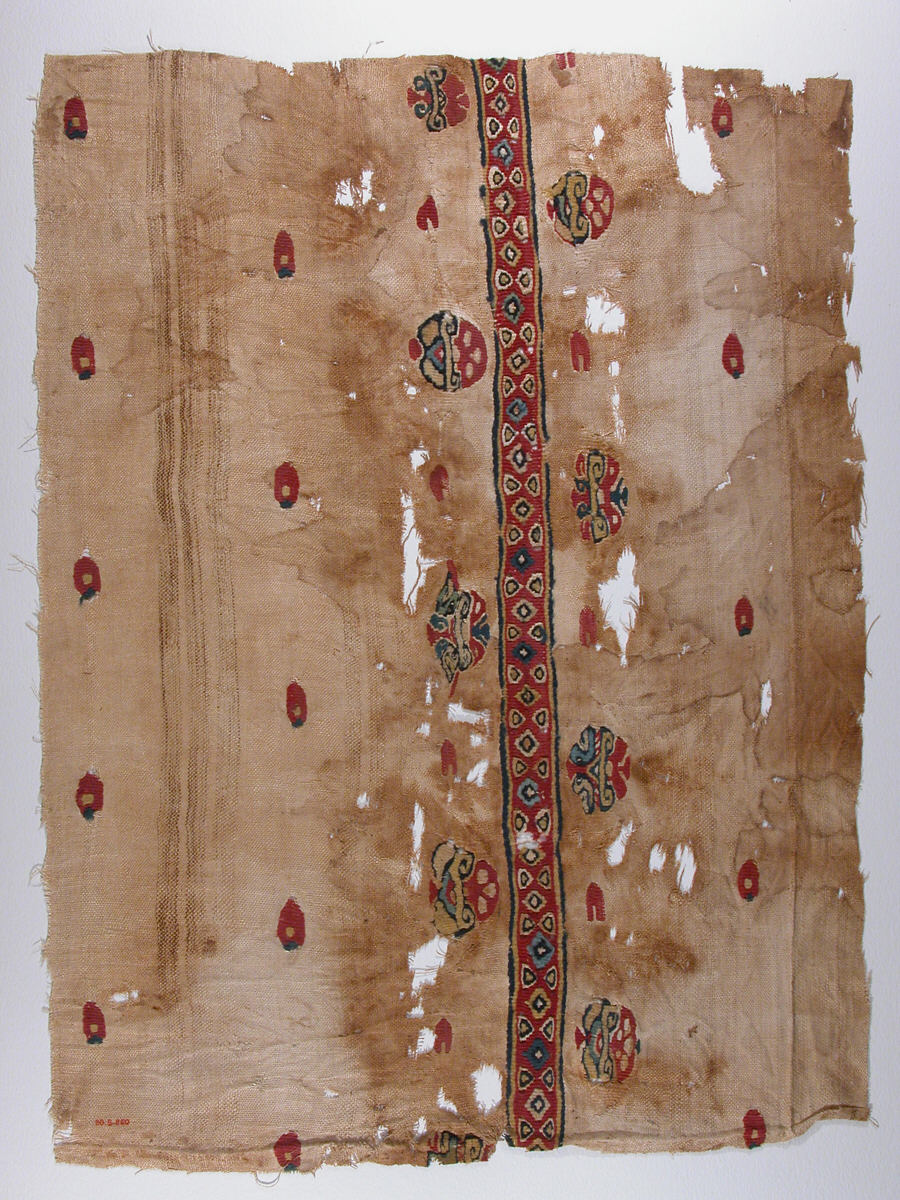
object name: textile fragment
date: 401-600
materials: linen, wool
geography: egypt